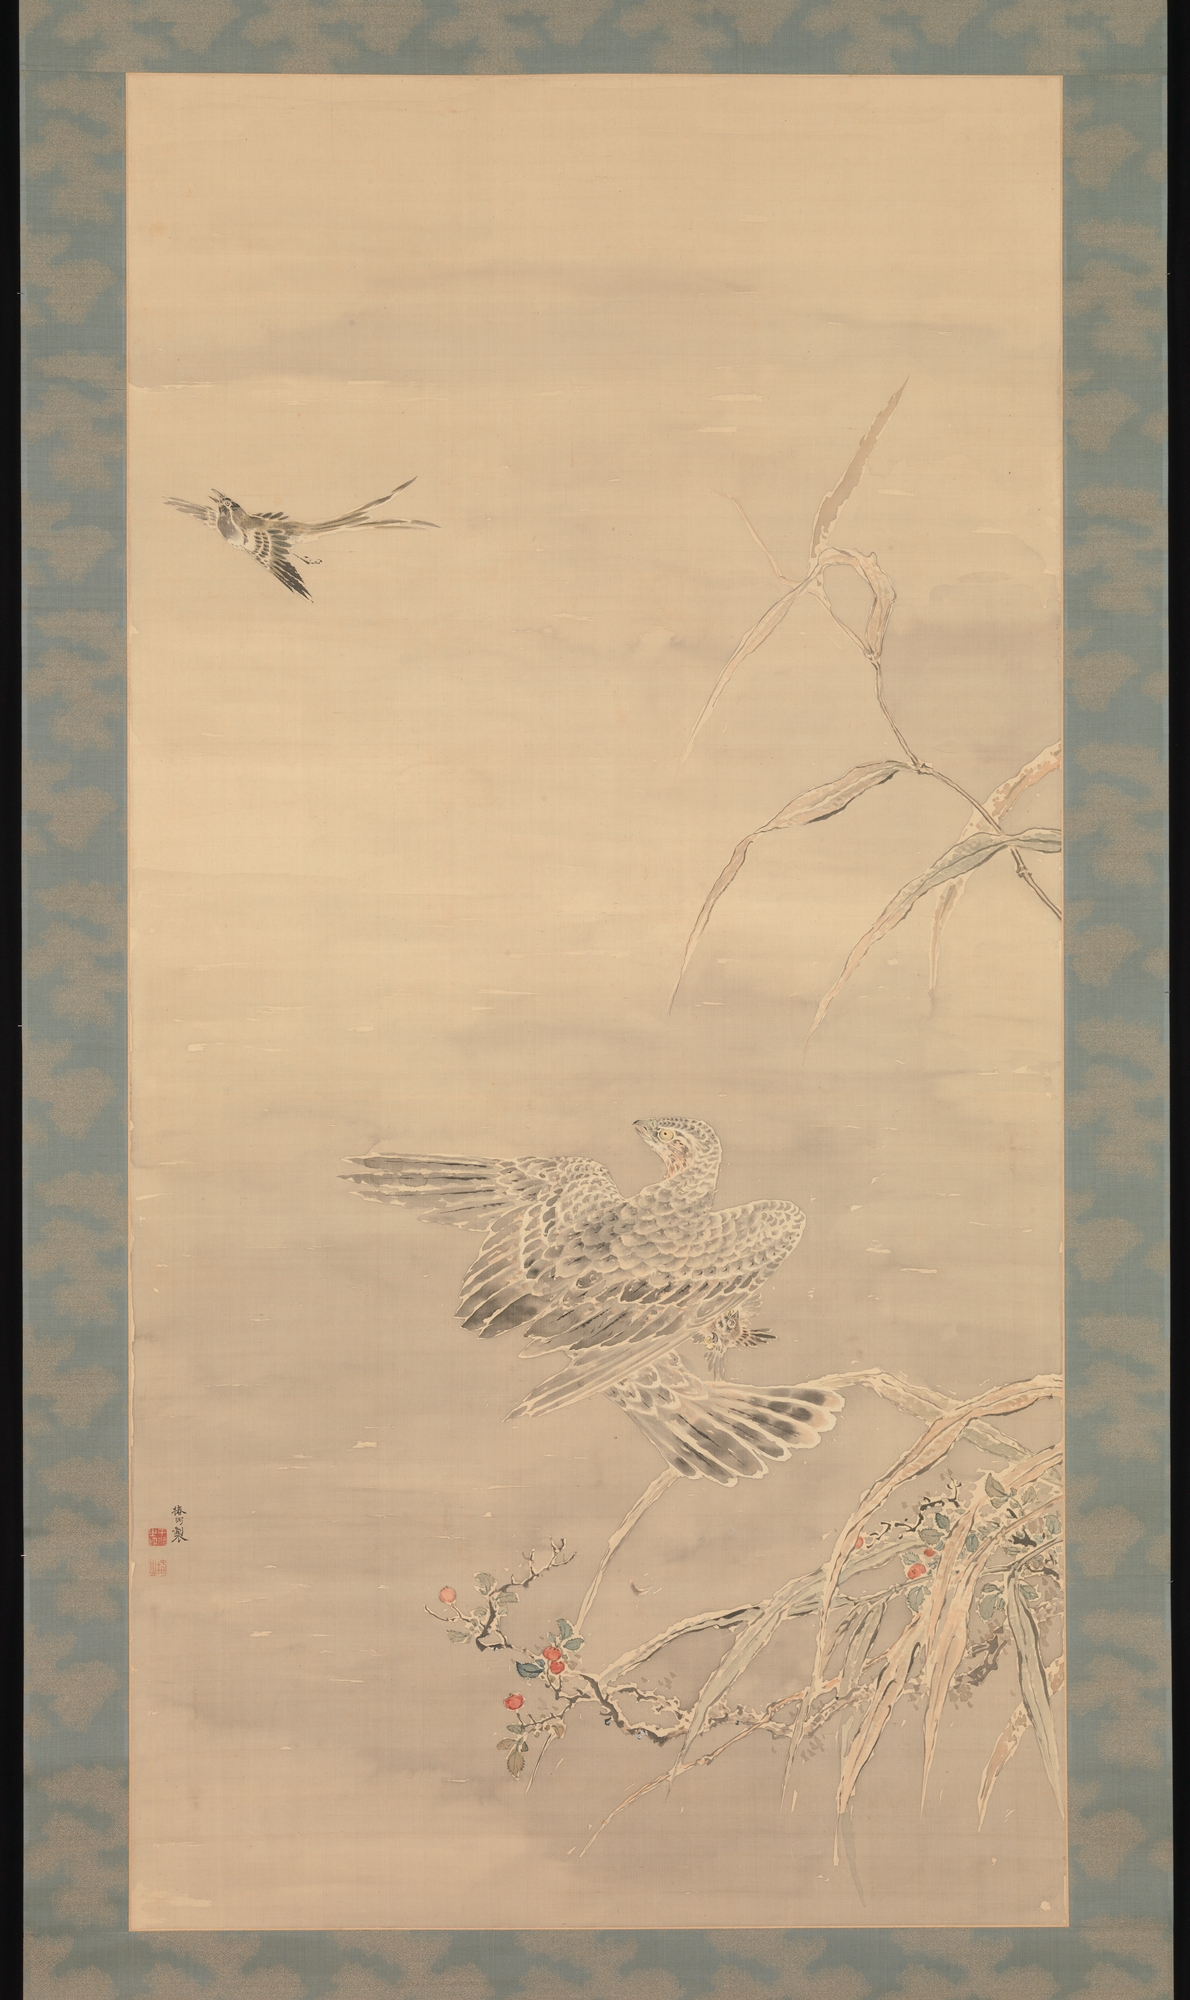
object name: hanging scroll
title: Hawk Grasping a Small Bird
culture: japanese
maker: tsubaki chinzan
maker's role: artist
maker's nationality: japanese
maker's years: 1801-1854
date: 1834-1866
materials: ink, paper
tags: birds,hawks